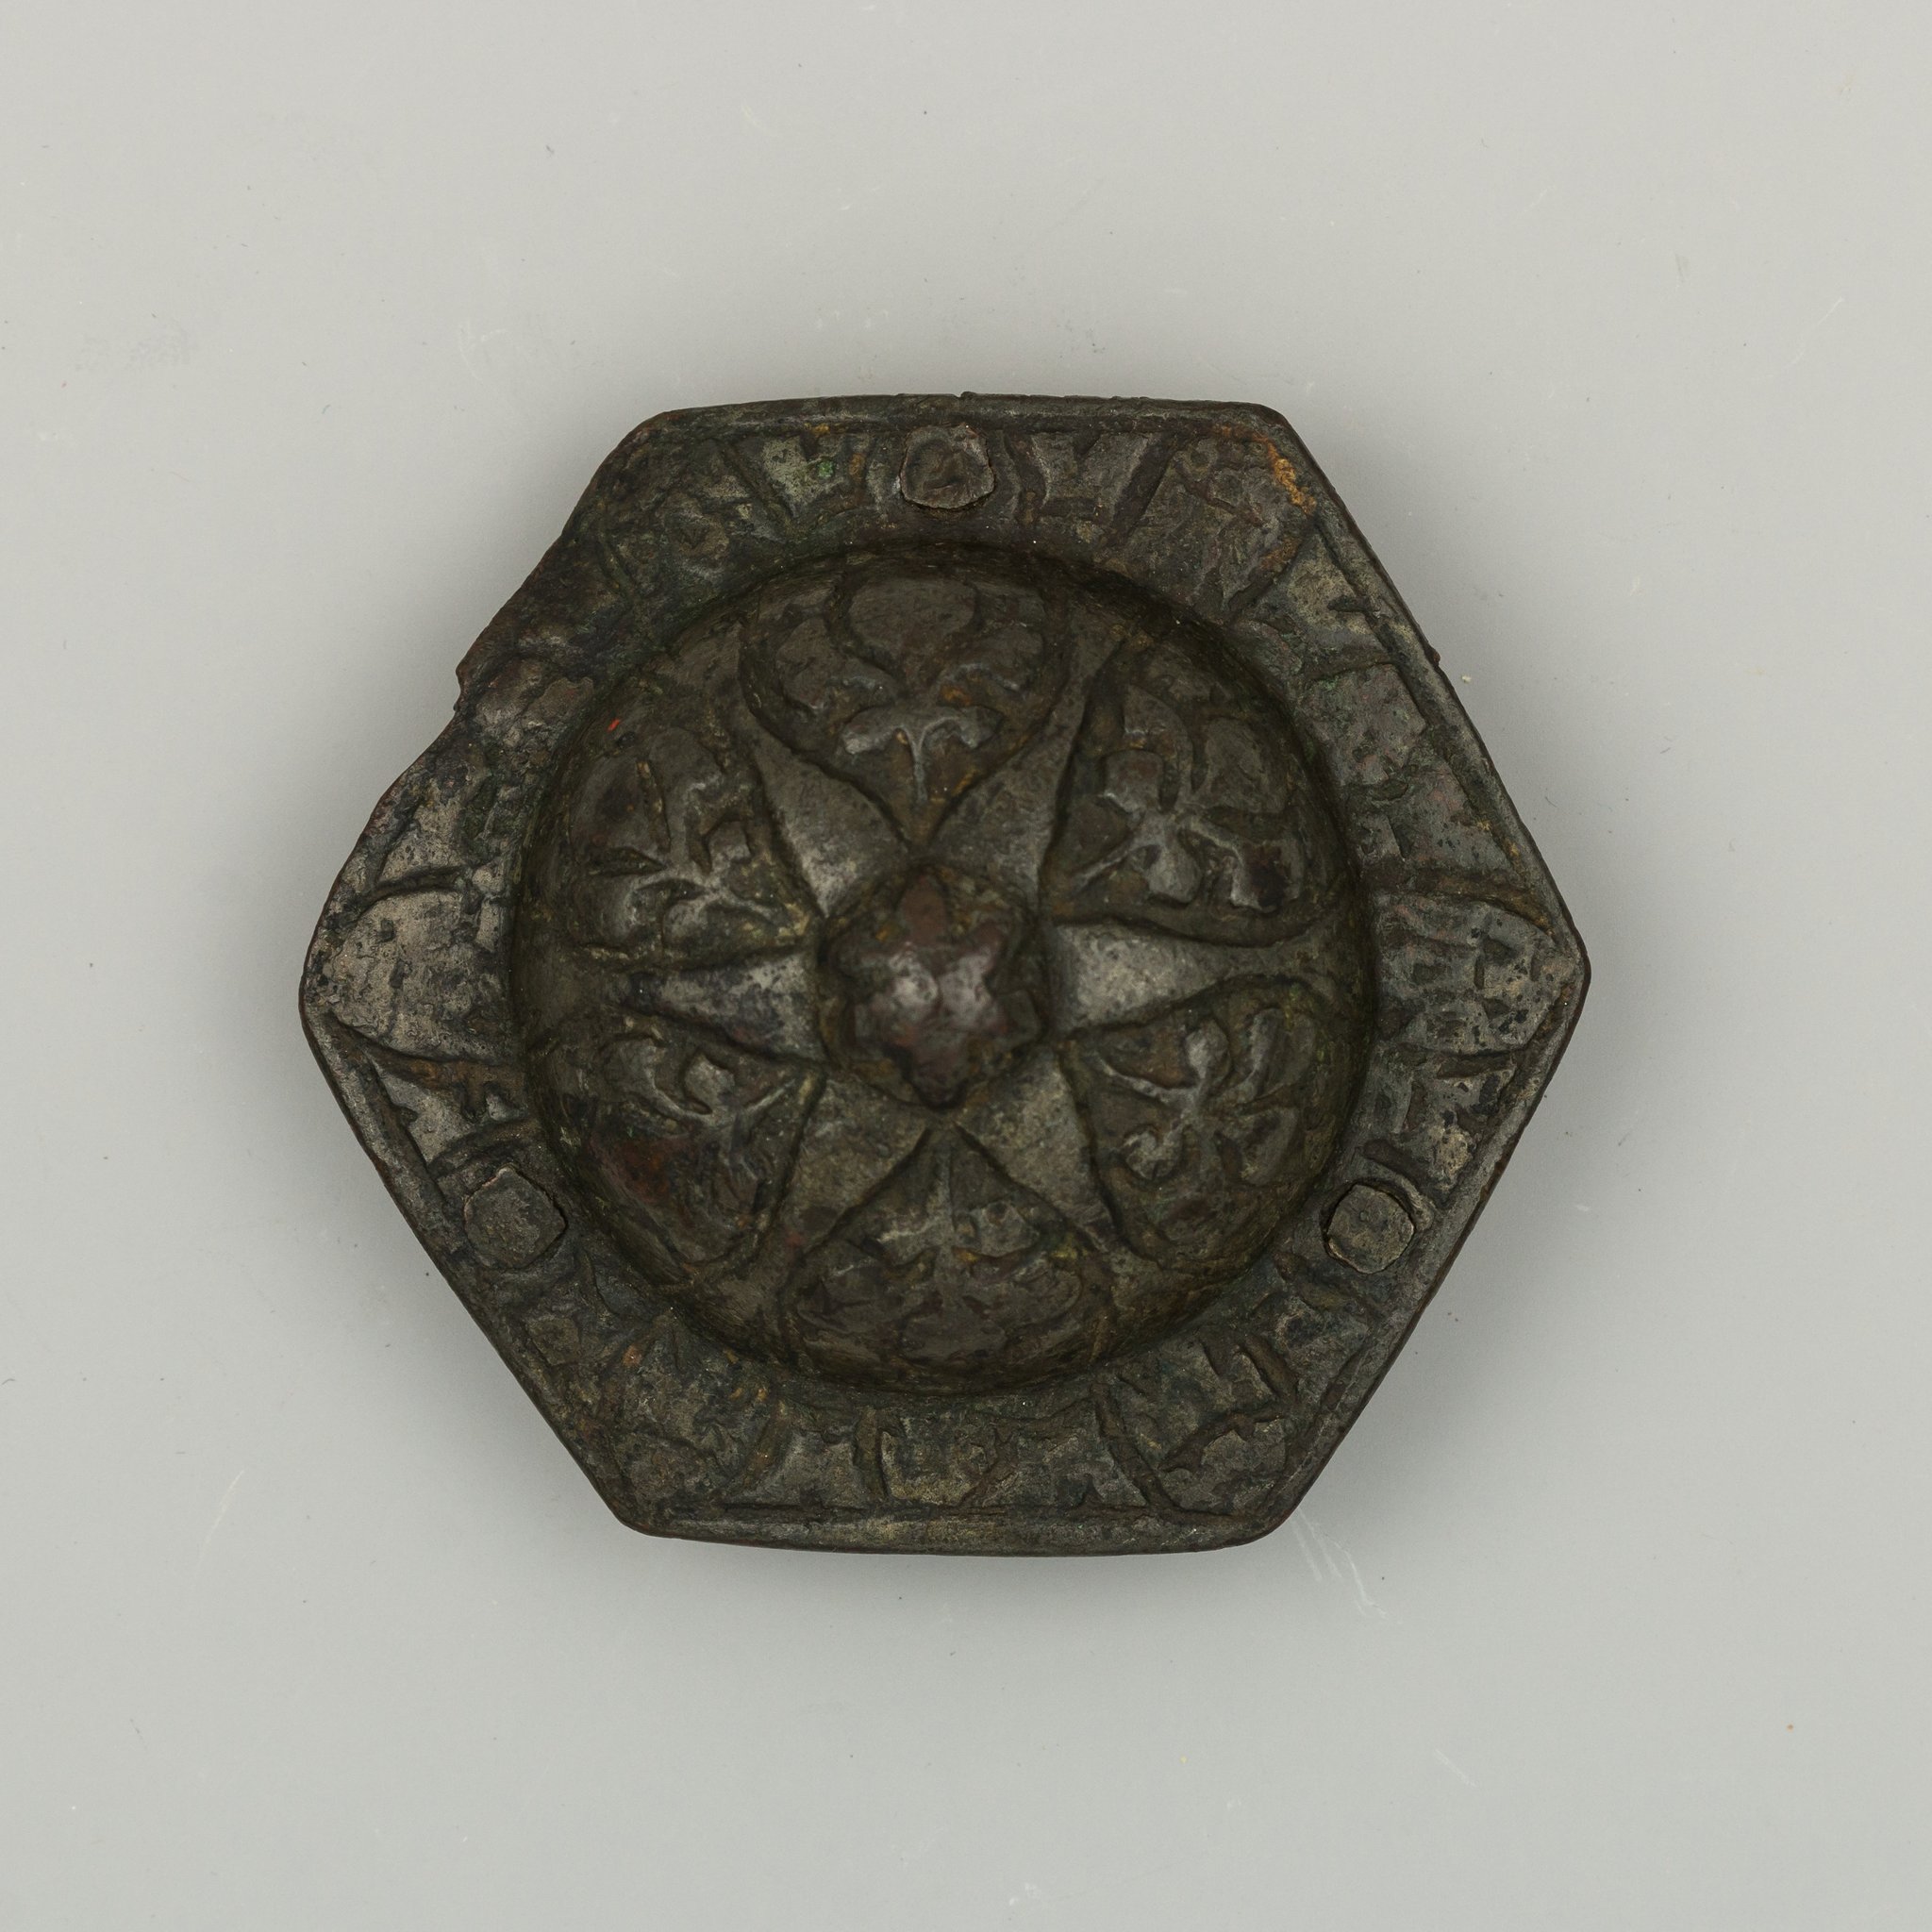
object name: harness ornament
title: Boss from a Horse Breast Collar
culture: ottoman or tatar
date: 1667-1800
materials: copper alloy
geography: ottoman empire